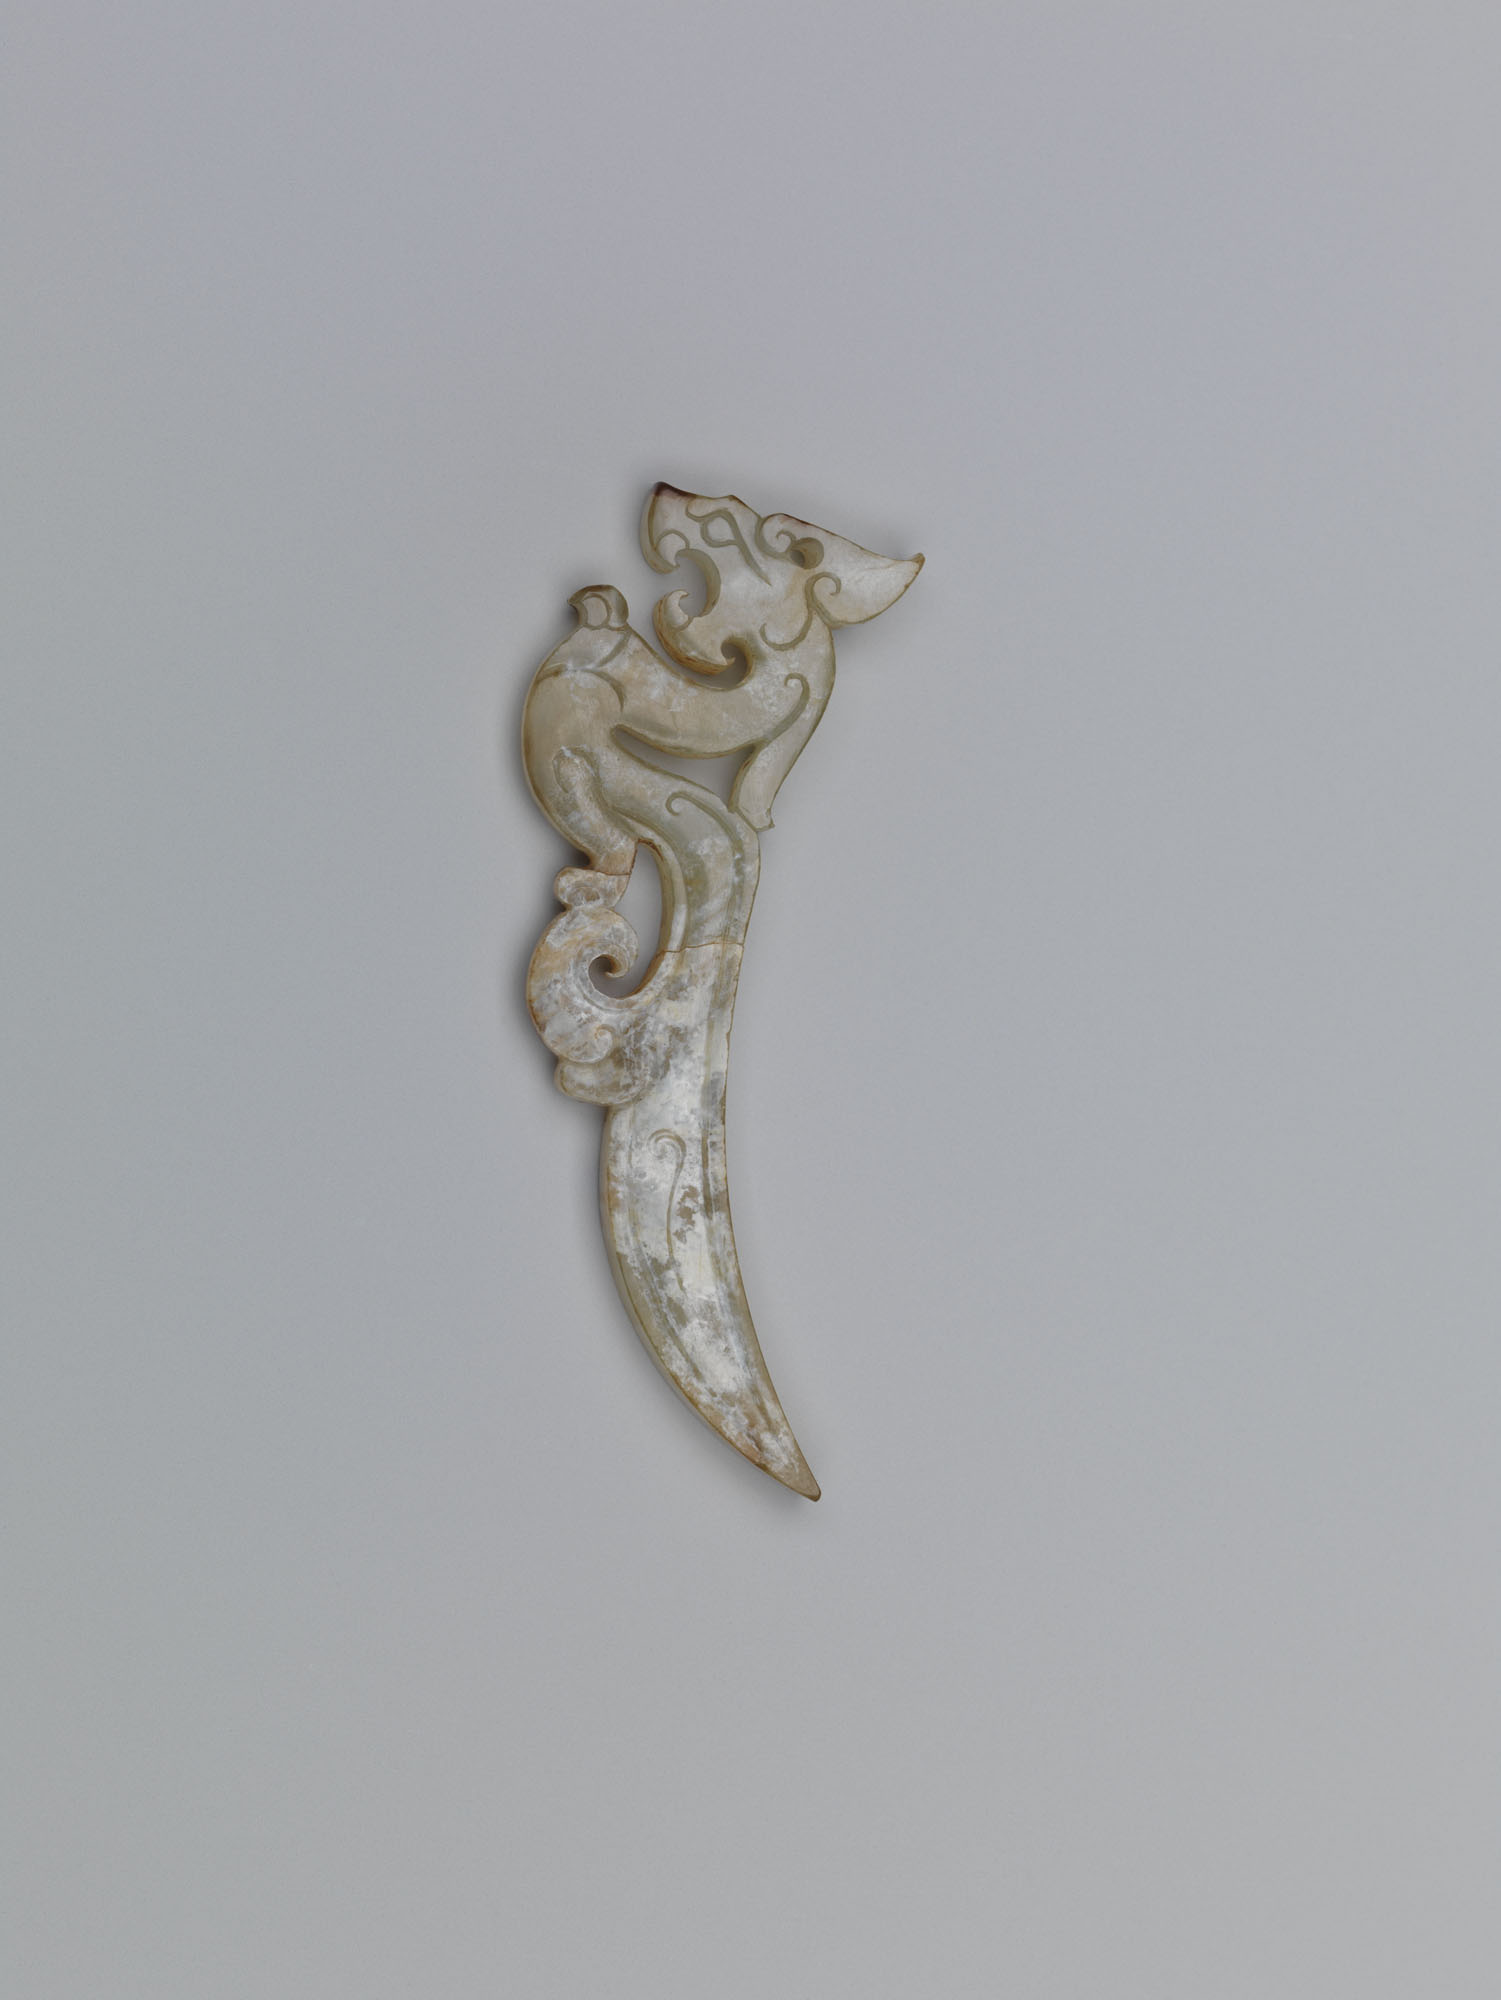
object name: pendant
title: Pendant in the shape of a dragon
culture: chinese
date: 300-201 BCE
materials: jade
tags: dragons